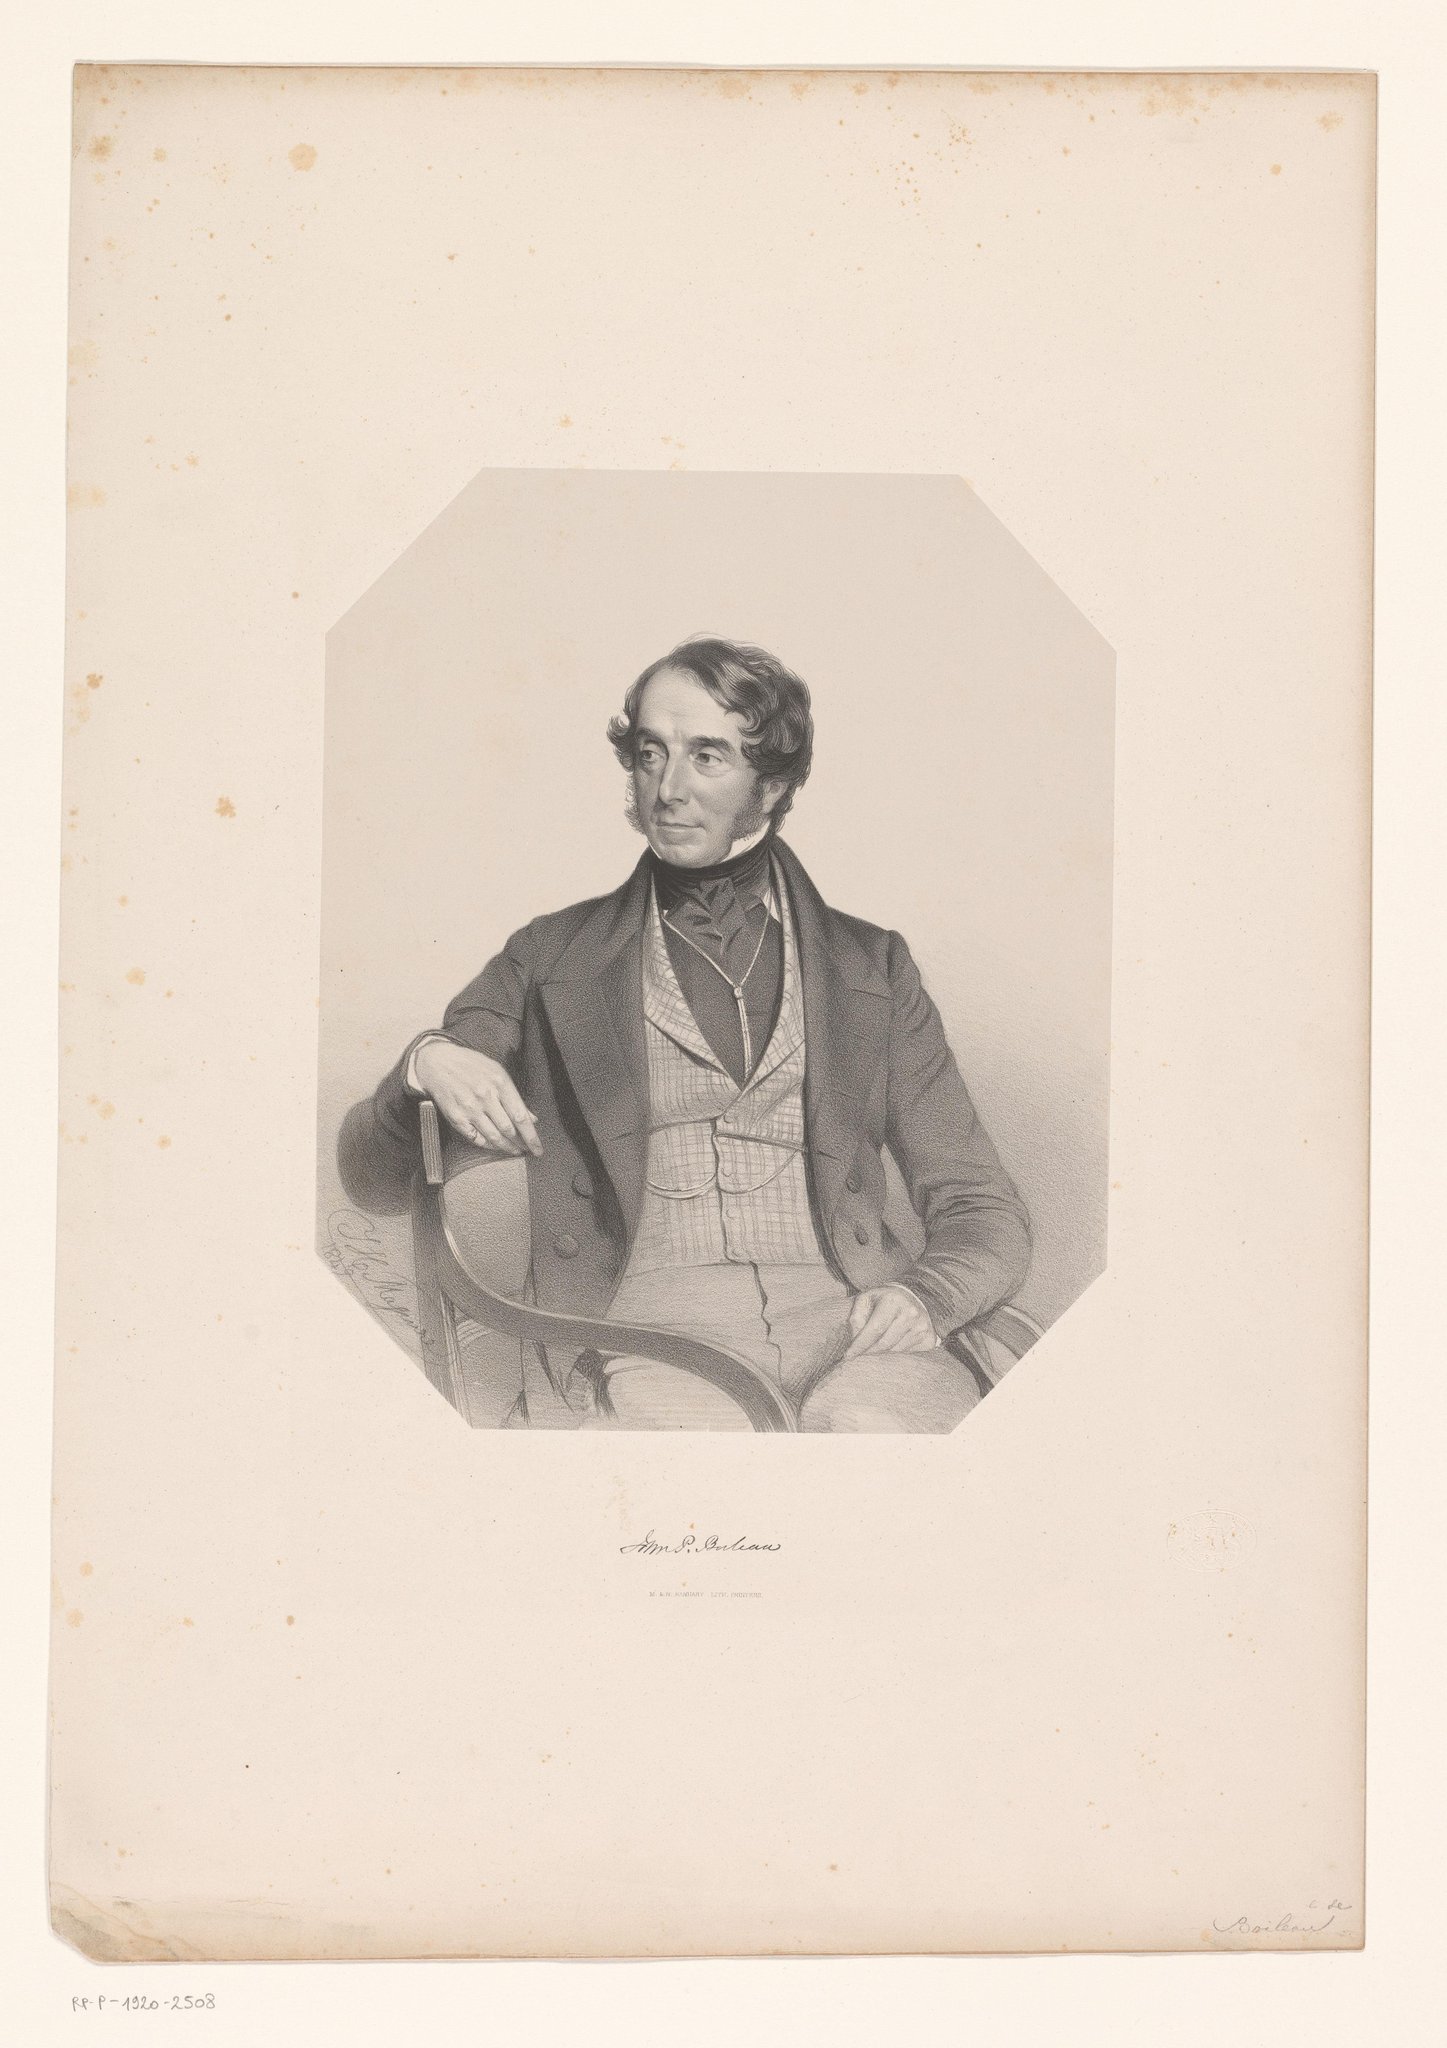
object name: print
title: Ipswich Museum Portraits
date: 1852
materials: paper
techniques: lithograph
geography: london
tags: adult man, historical persons, chair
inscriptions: collector's mark: Lugt 2228, check stamp: ‘Ipswich Museum’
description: Prent behoort tot de serie 'Ipswich Museum Portraits', ook bekend onder de titel 'Portraits of Honorary Members of the Ipswich Museum'. Deze serie is in 1852 door George Ransome uitgegeven en gedrukt door M&N Hanhart tussen 1848 en 1852. De serie bestaat uit ca. 60 portretten.